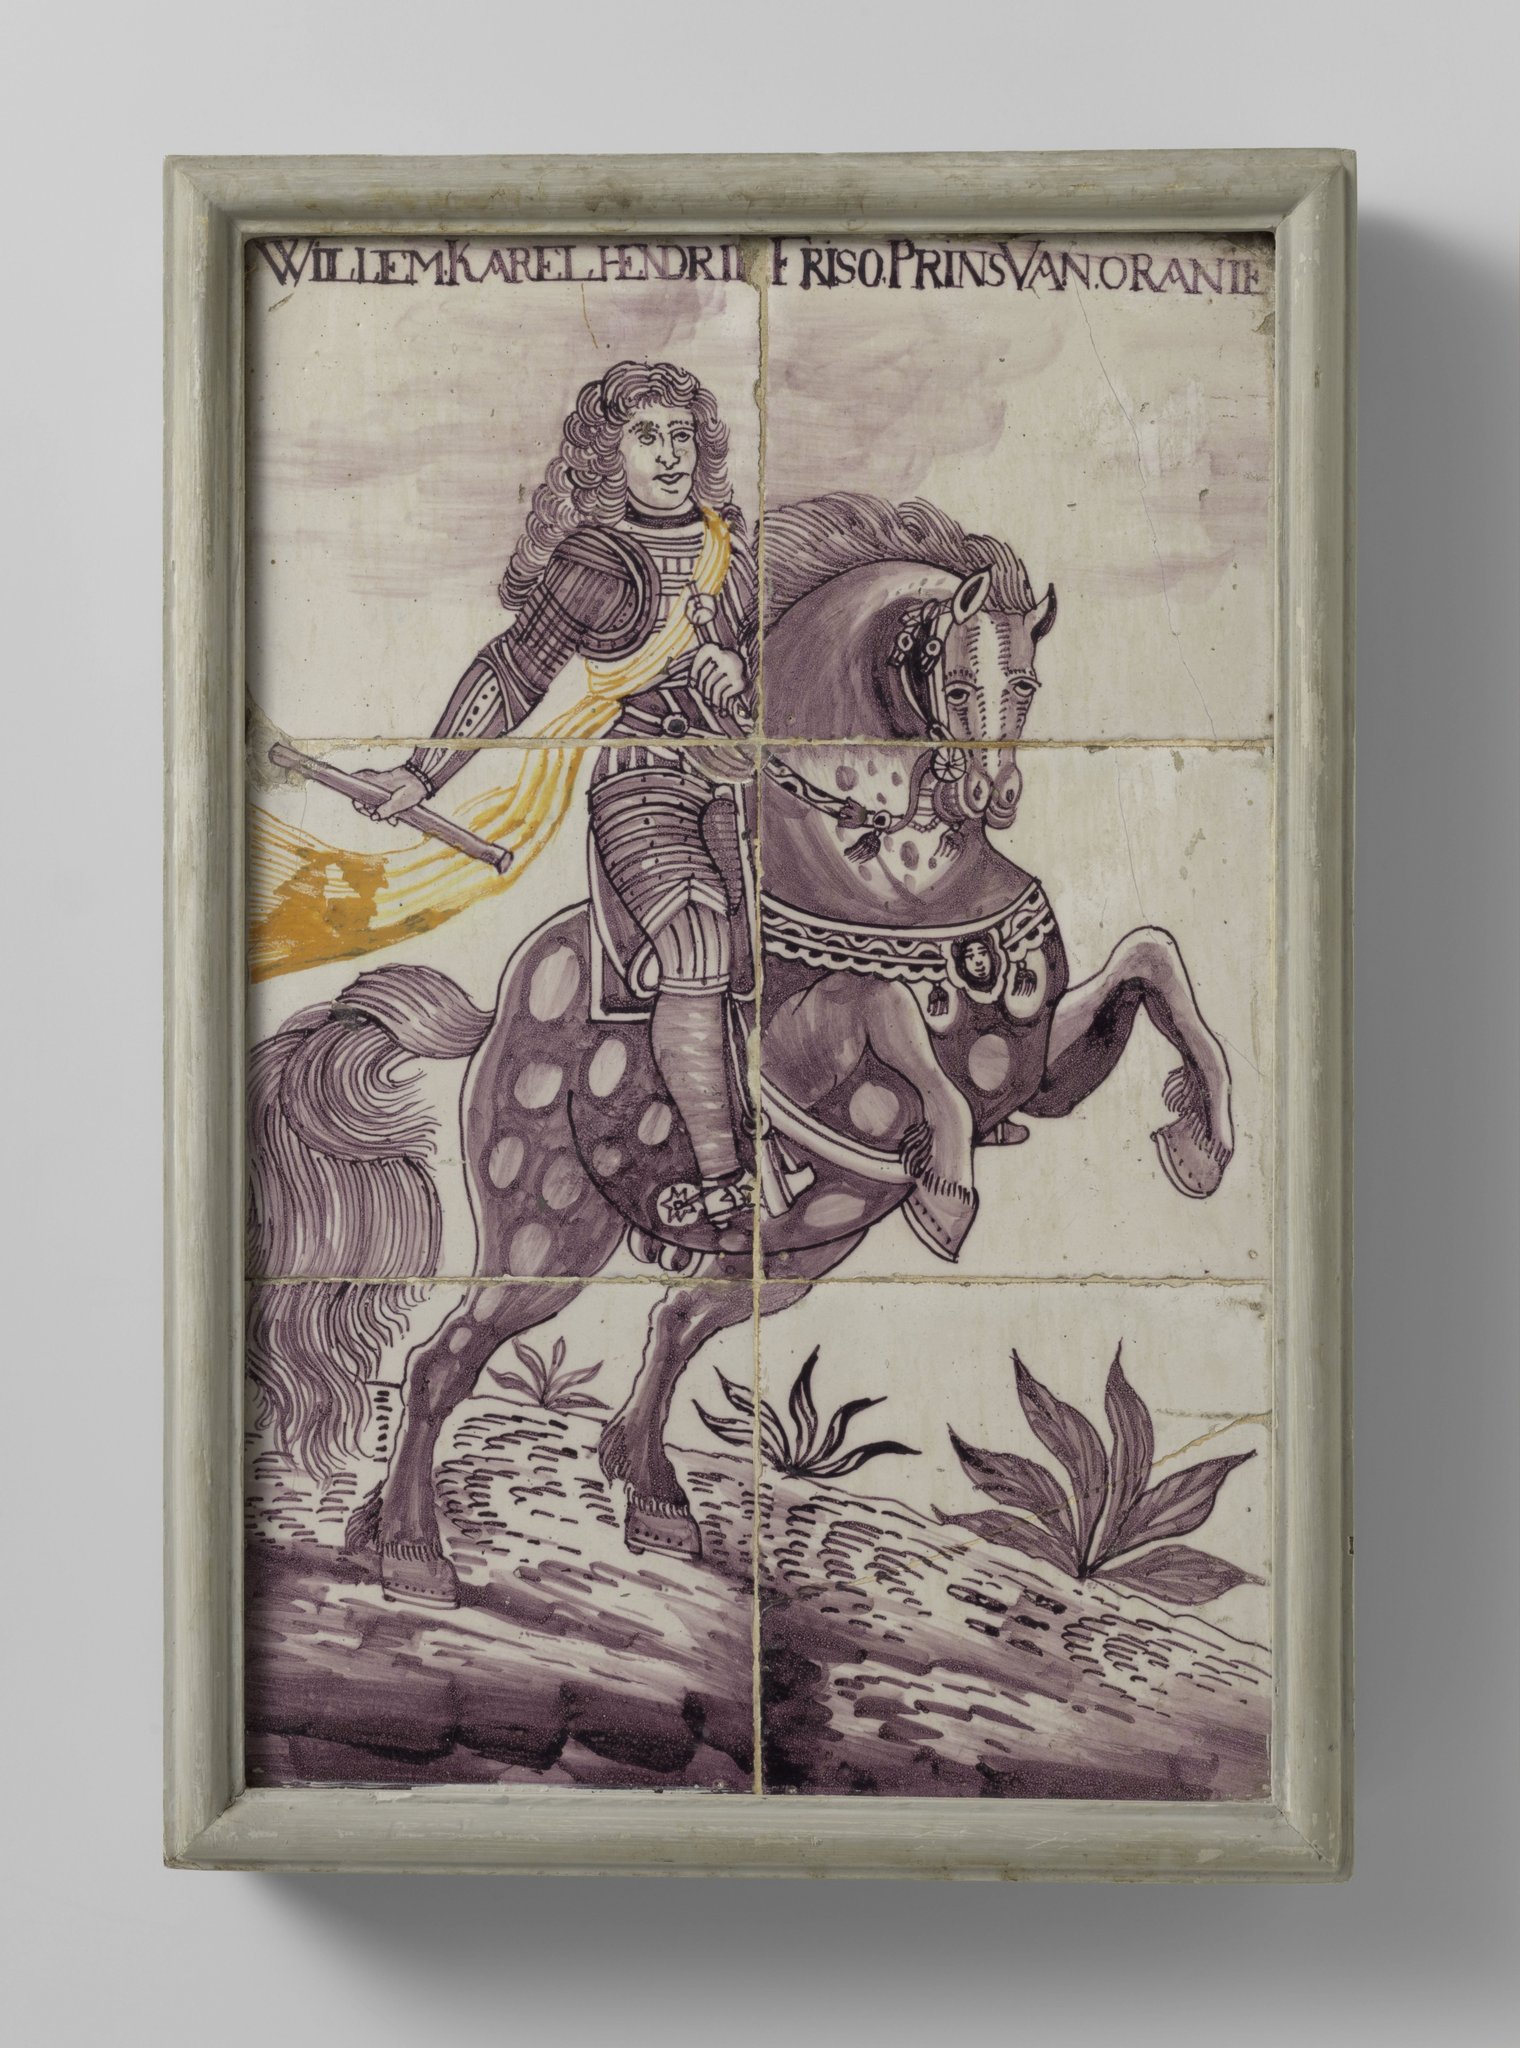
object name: tile tableau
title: Tegeltableau met portret prins Willem IV te paard, met opschrift: WILLEM KAREL HENDRIK FRISO PRINS VAN ORANIE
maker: Anonymous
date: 1760-1795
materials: earthenware, glaze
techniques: maiolica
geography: netherlands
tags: the hague, willem iv (prins van oranje-nassau)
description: Tegeltableau van 6 tegels (3 x 2) met een veelkleurig (paars en geel) geschilderd portret van prins Willem IV te paard. Aan de bovenkant, het opschrift: WILLEM KAREL HENDRIK FRISO PRINS VAN ORANIE.